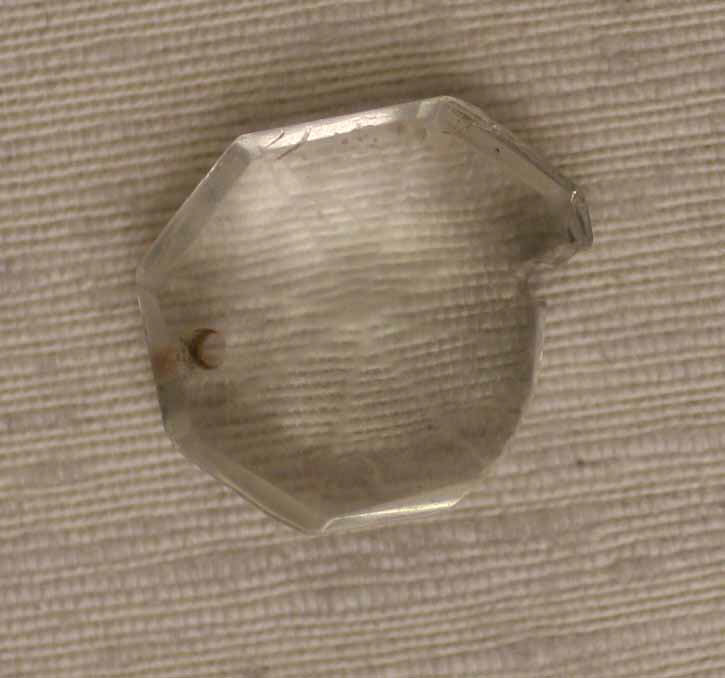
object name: bead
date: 701-1300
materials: quartz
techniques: cutting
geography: iran